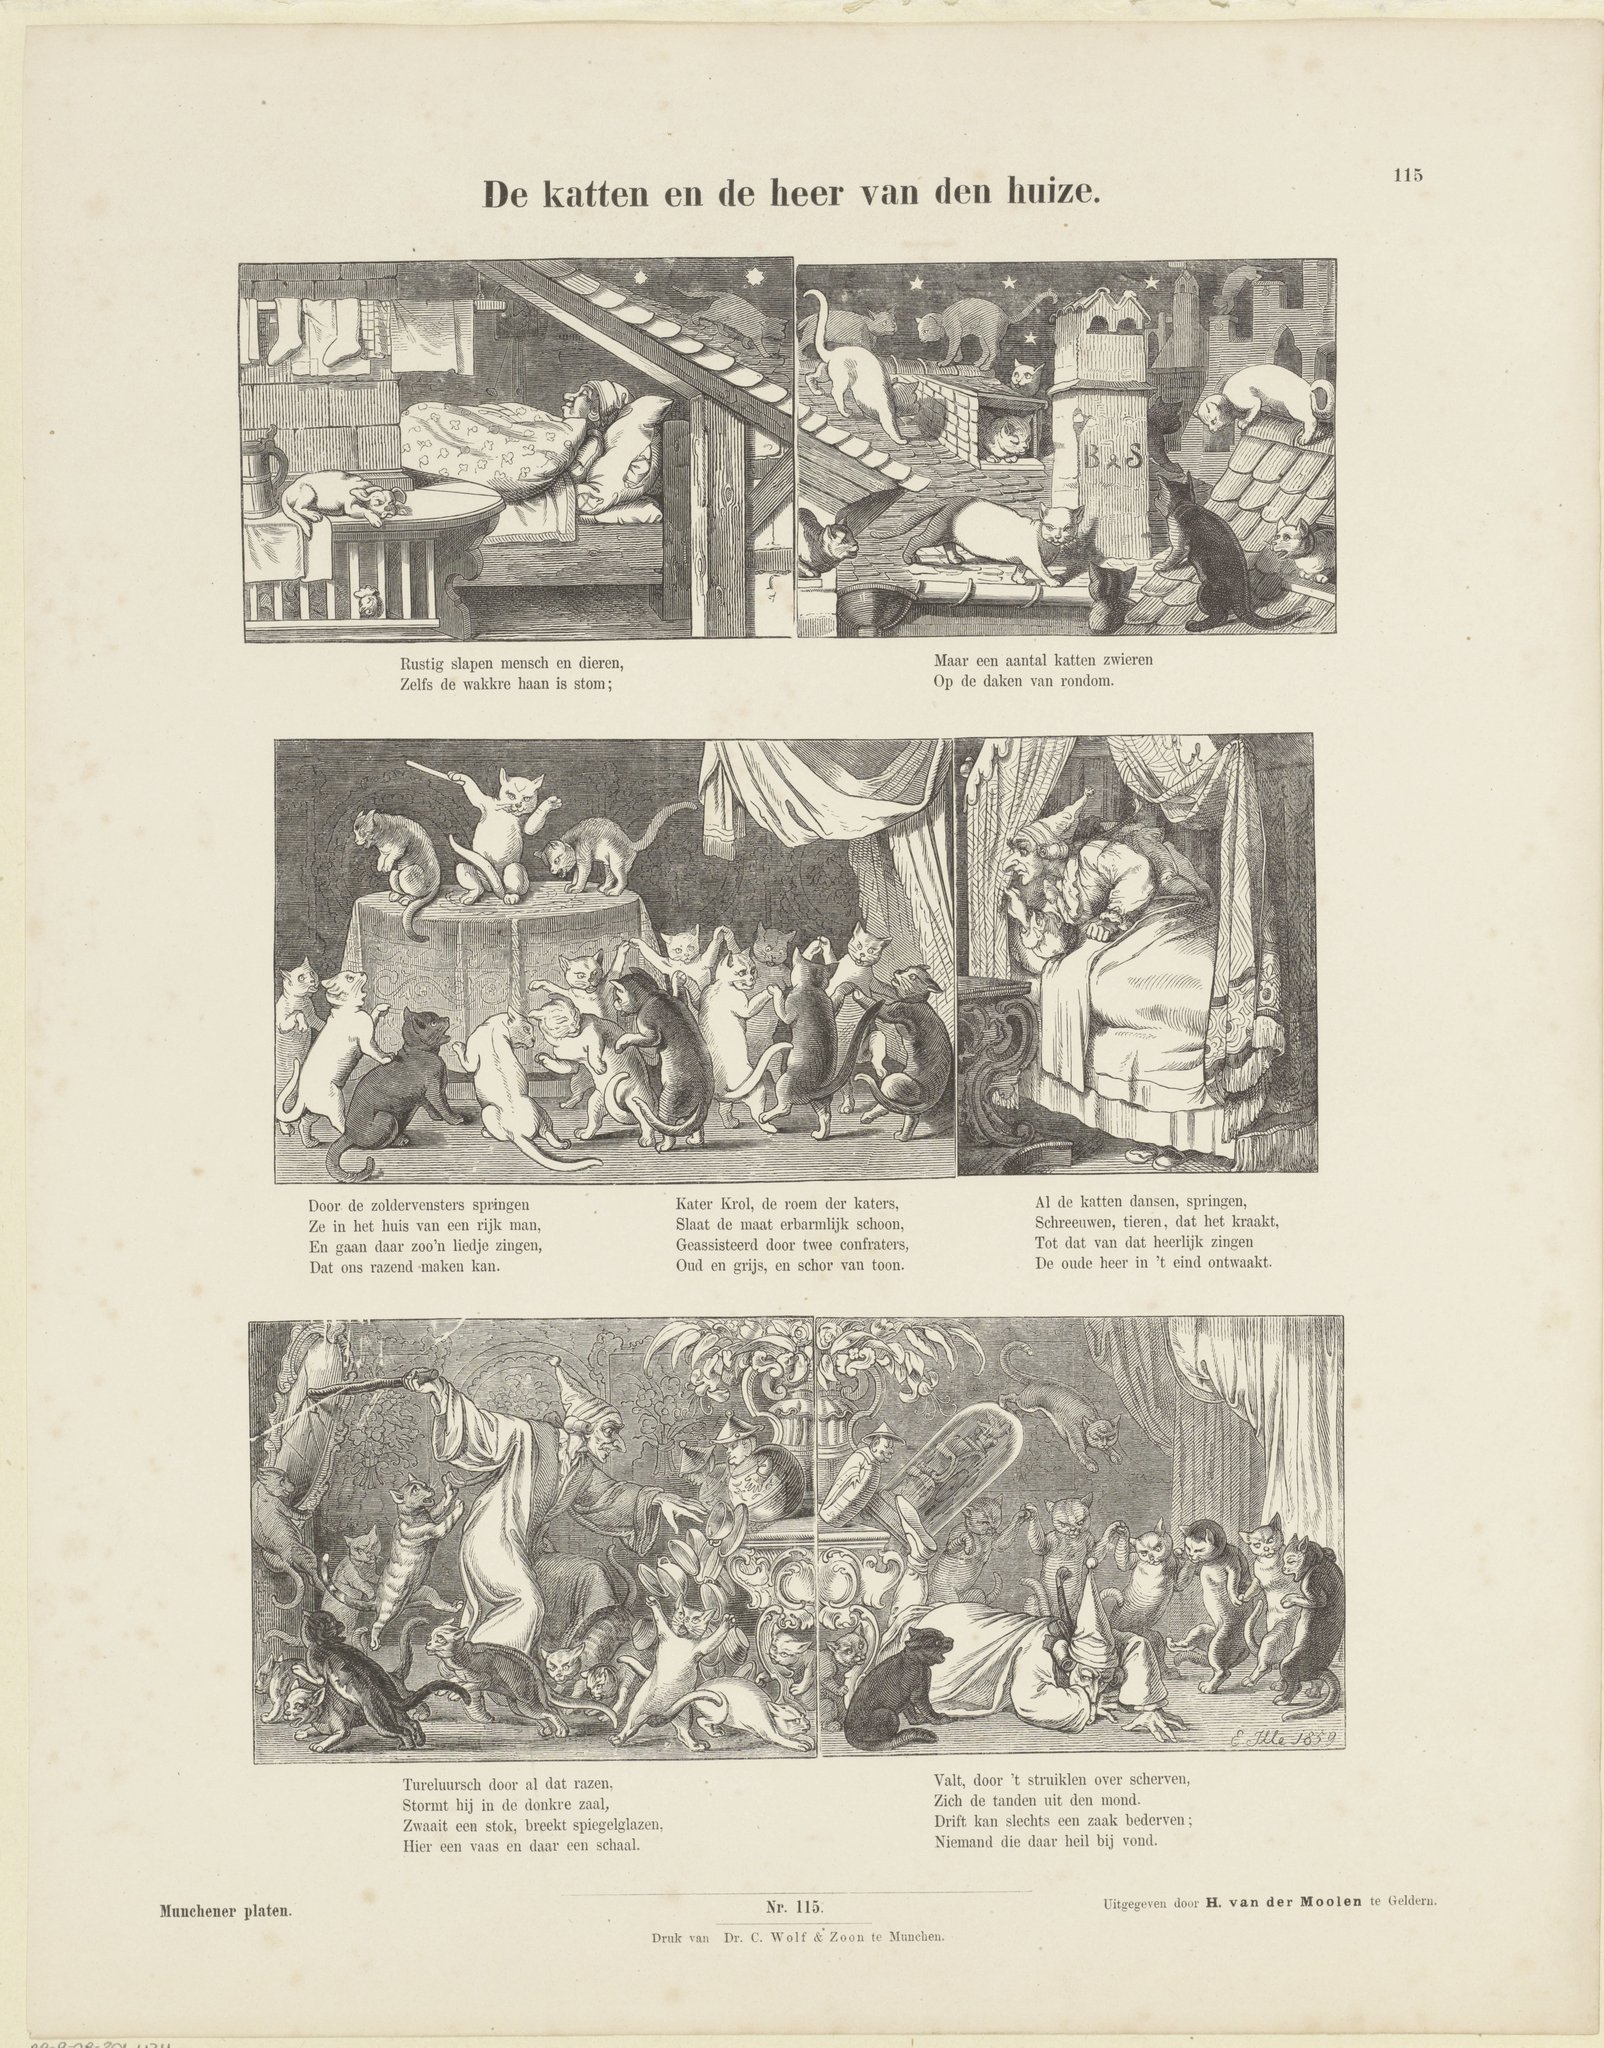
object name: popular print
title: Munchener platen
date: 1859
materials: paper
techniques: letterpress printing, engraving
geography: munich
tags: cat, sleeping in bed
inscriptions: collector's mark: Lugt 2760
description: Blad met 6 voorstellingen over de heer des huizes wordt door kattengejank uit zijn slaap gehouden. In zijn woede richt hij een ravage aan. Onder elke afbeelding een onderschrift. Genummerd midden onder: Nro. 115. Genummerd rechtsboven: 115.